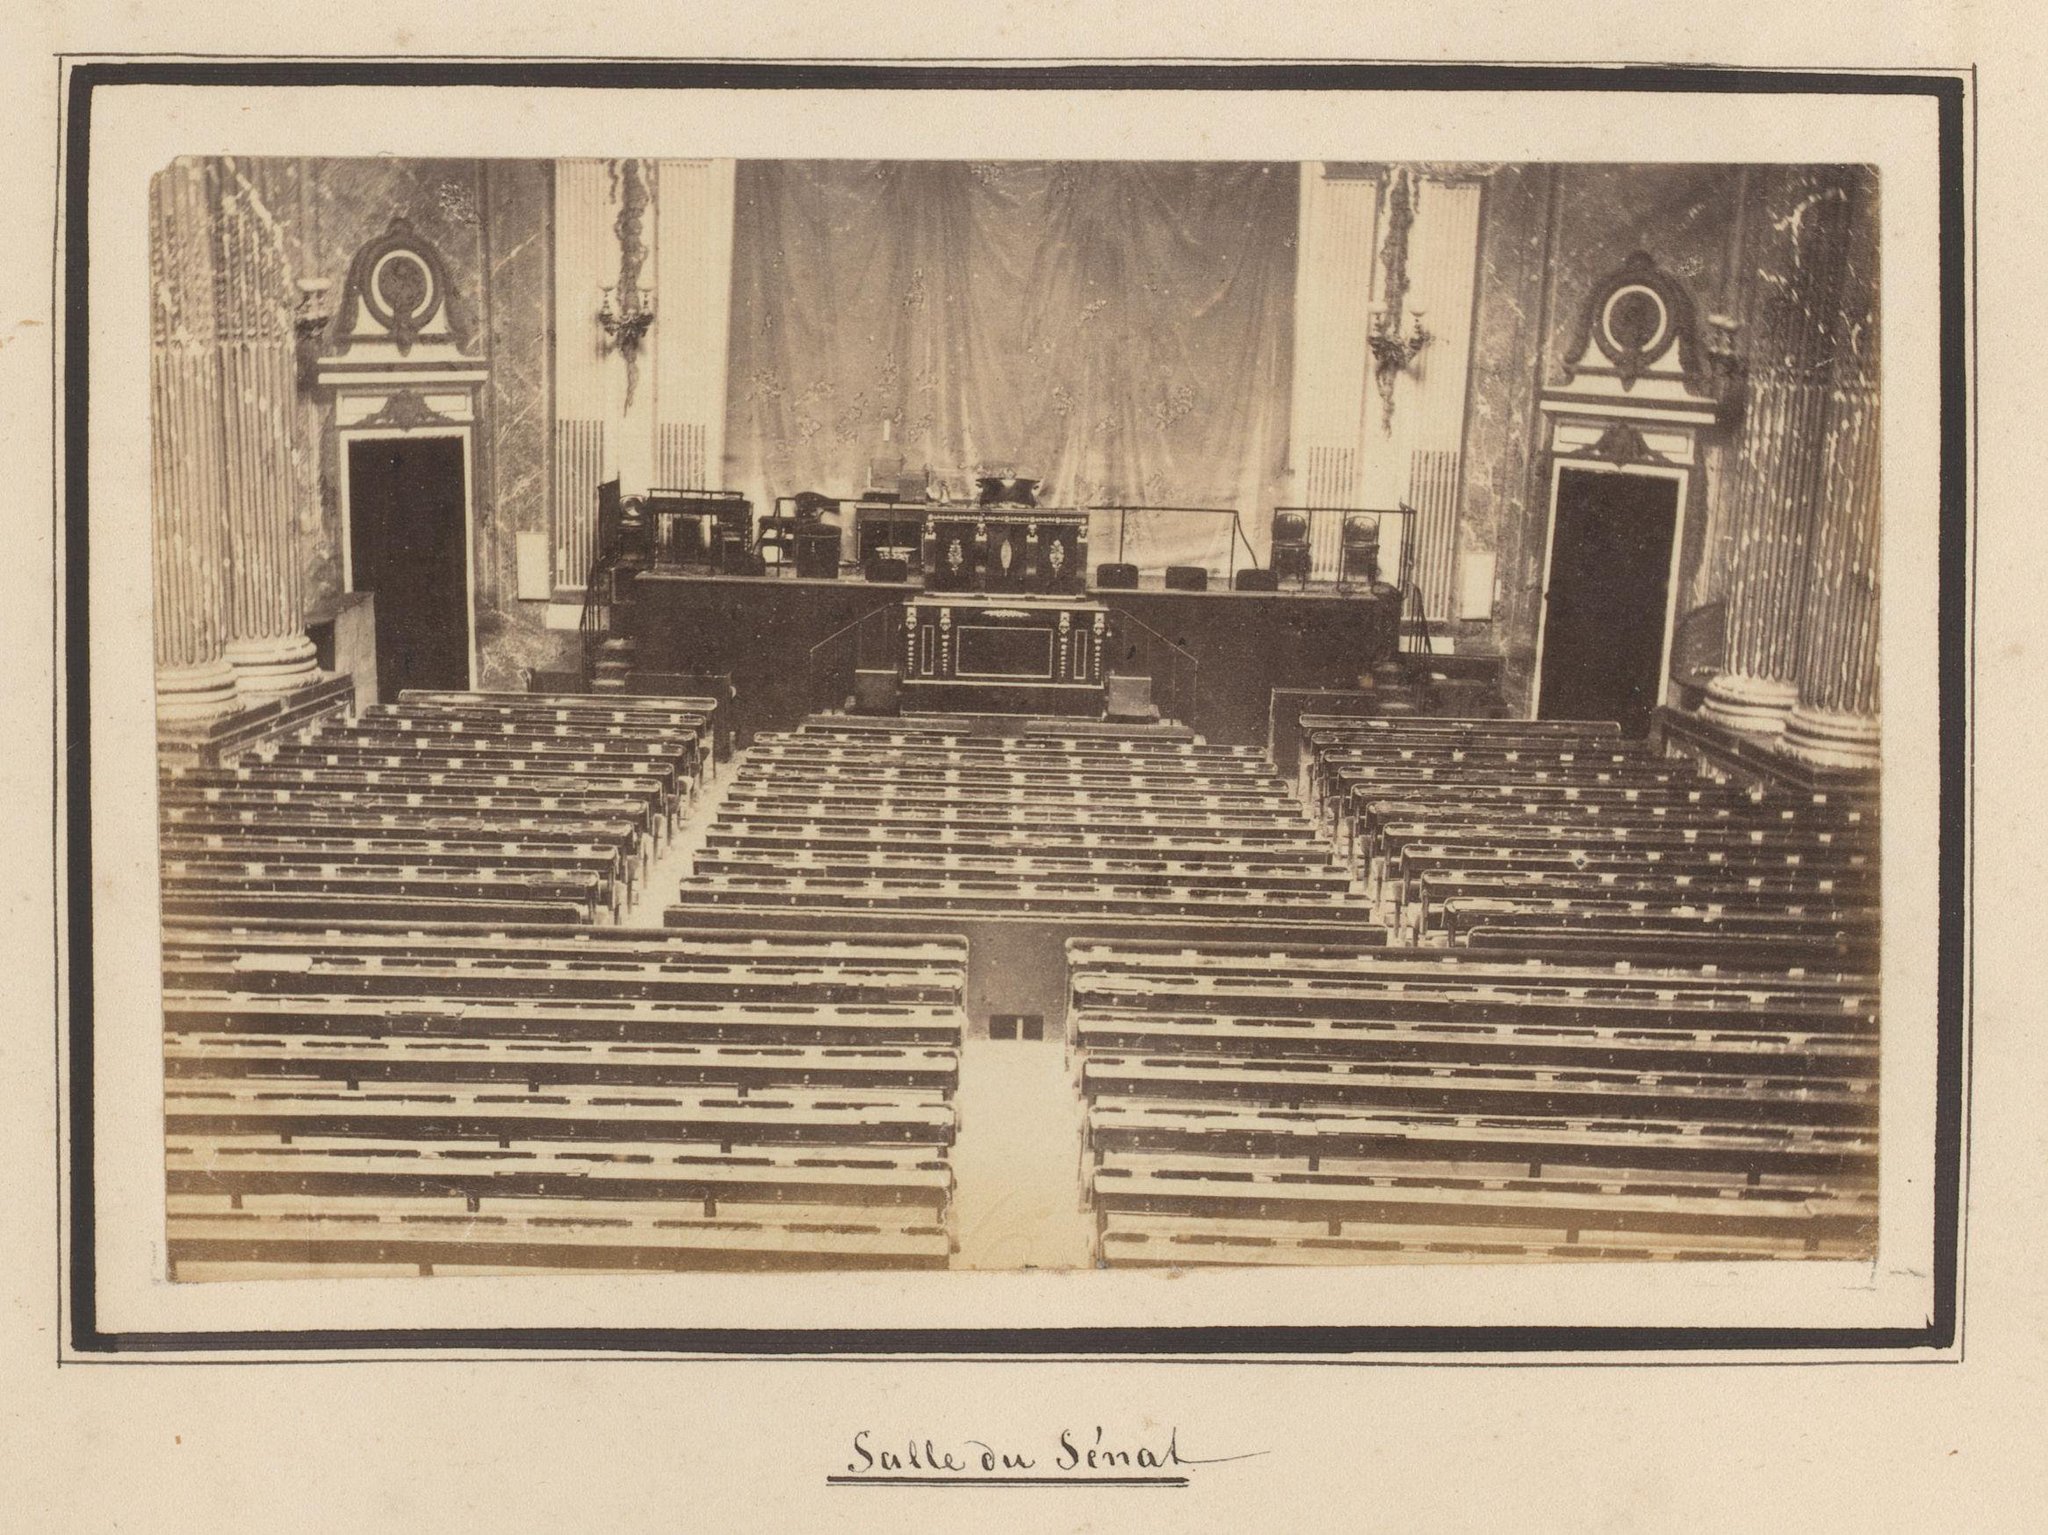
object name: album leaf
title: Plenaire zaal van de Franse Senaat, Parijs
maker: Anonymous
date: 1870-1890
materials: paper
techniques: albumen print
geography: paris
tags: upper house, senate, paris